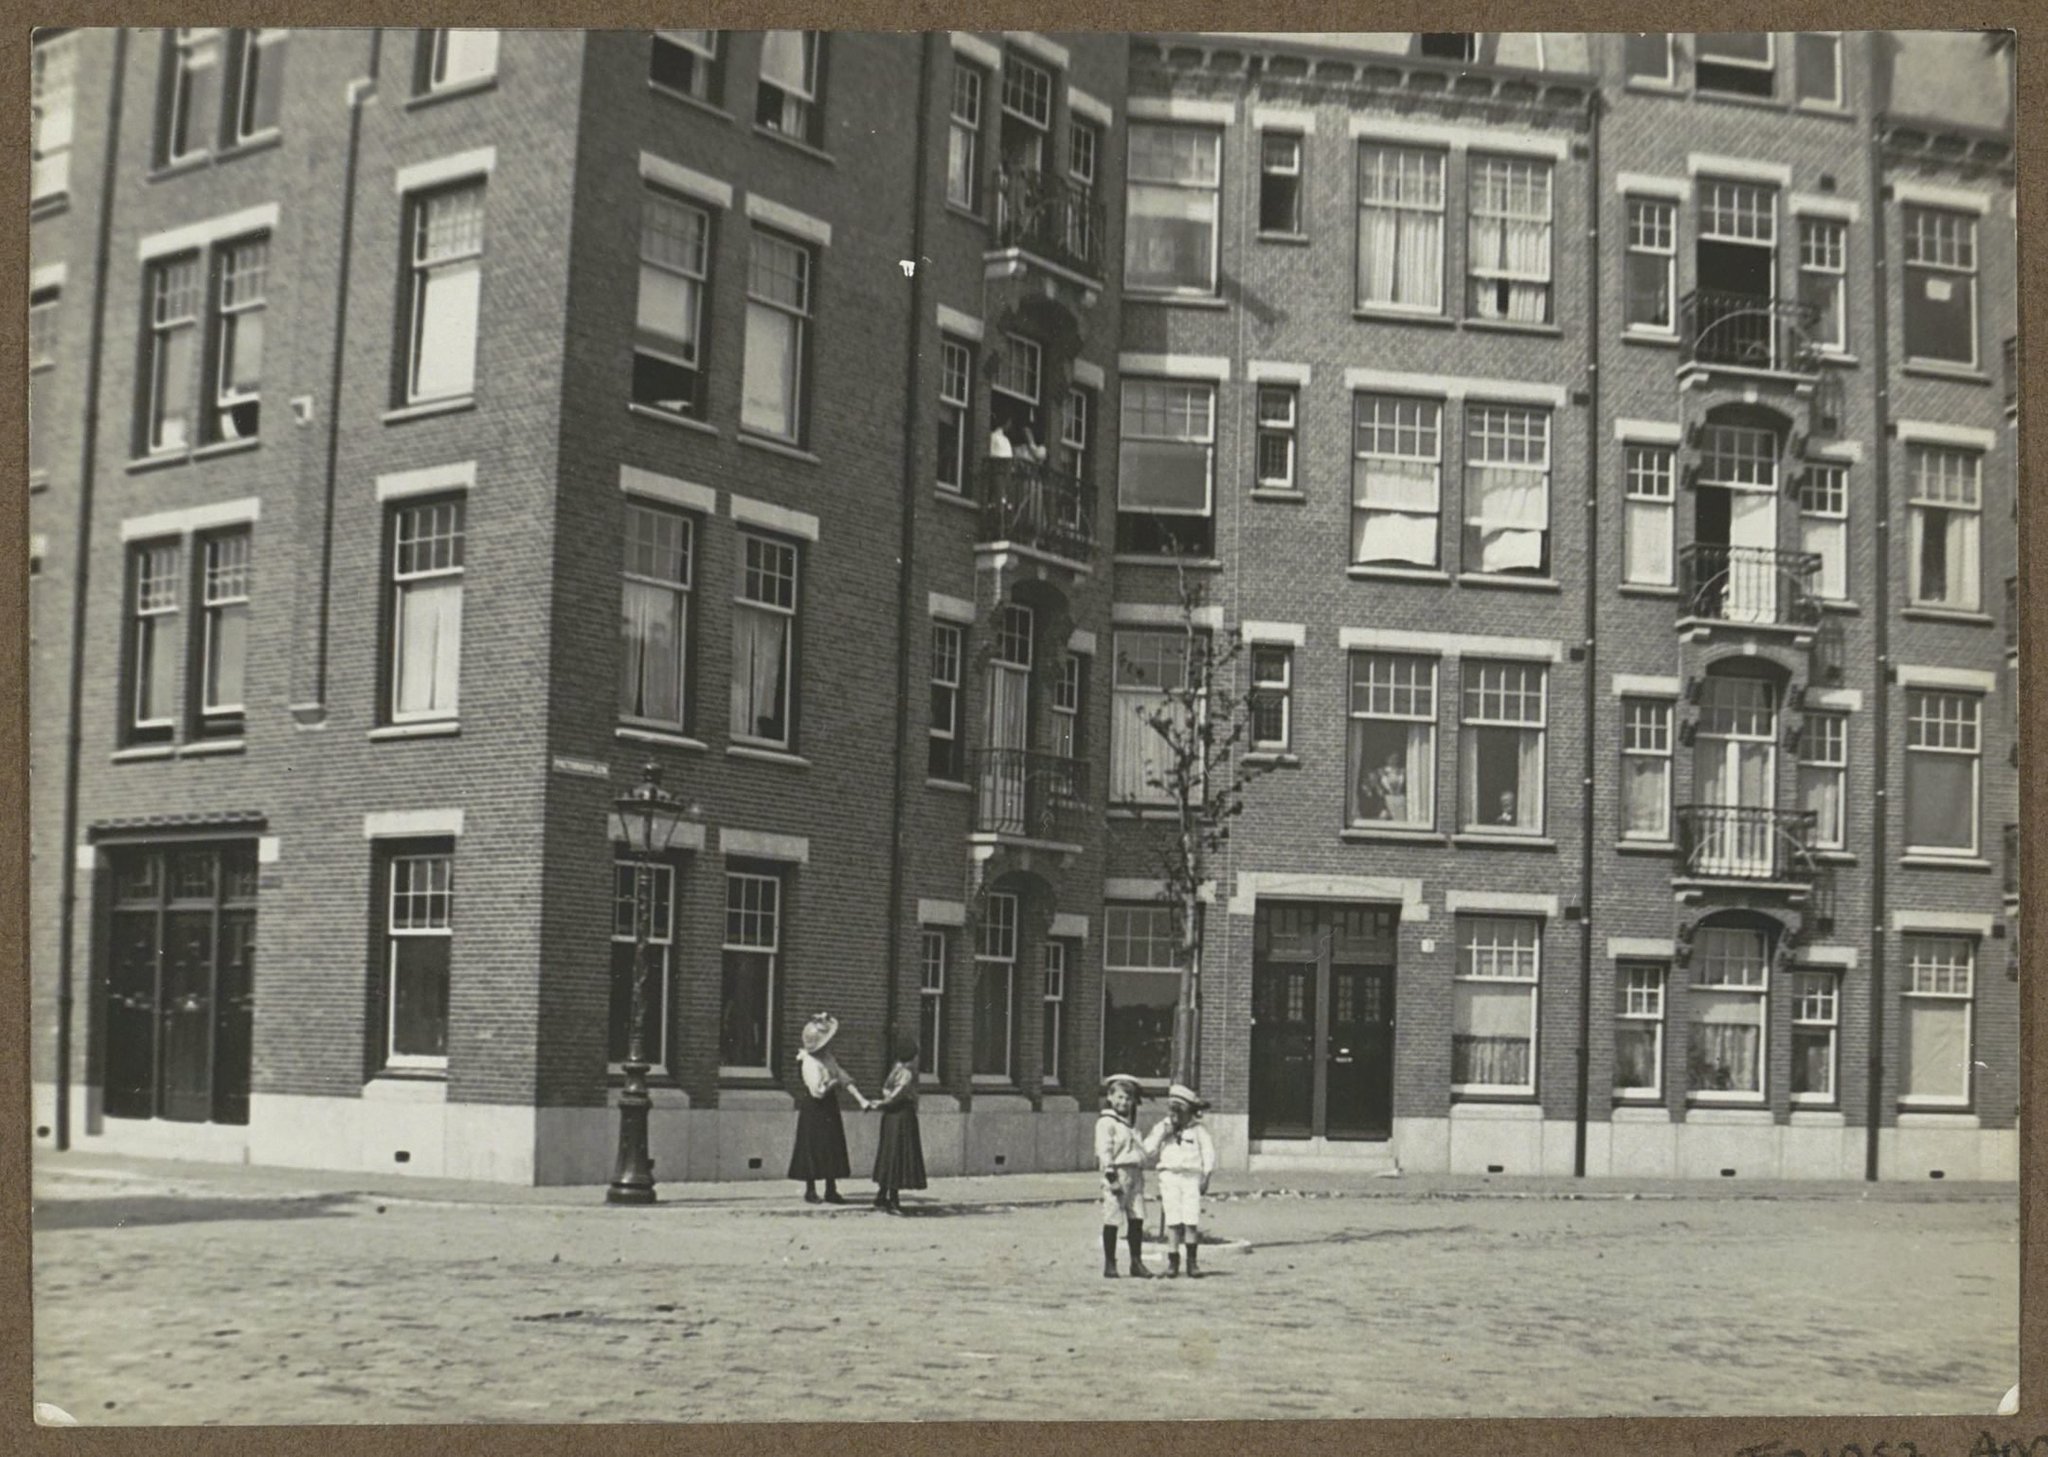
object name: photograph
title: Huizenblok aan het Pretoriusplein te Amsterdam met kinderen op straat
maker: Anonymous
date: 1910-1930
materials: paper, photographic support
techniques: gelatin silver print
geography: amsterdam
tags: façade (of house or building)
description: Onderdeel van Album met foto's van Amsterdam en omgeving.